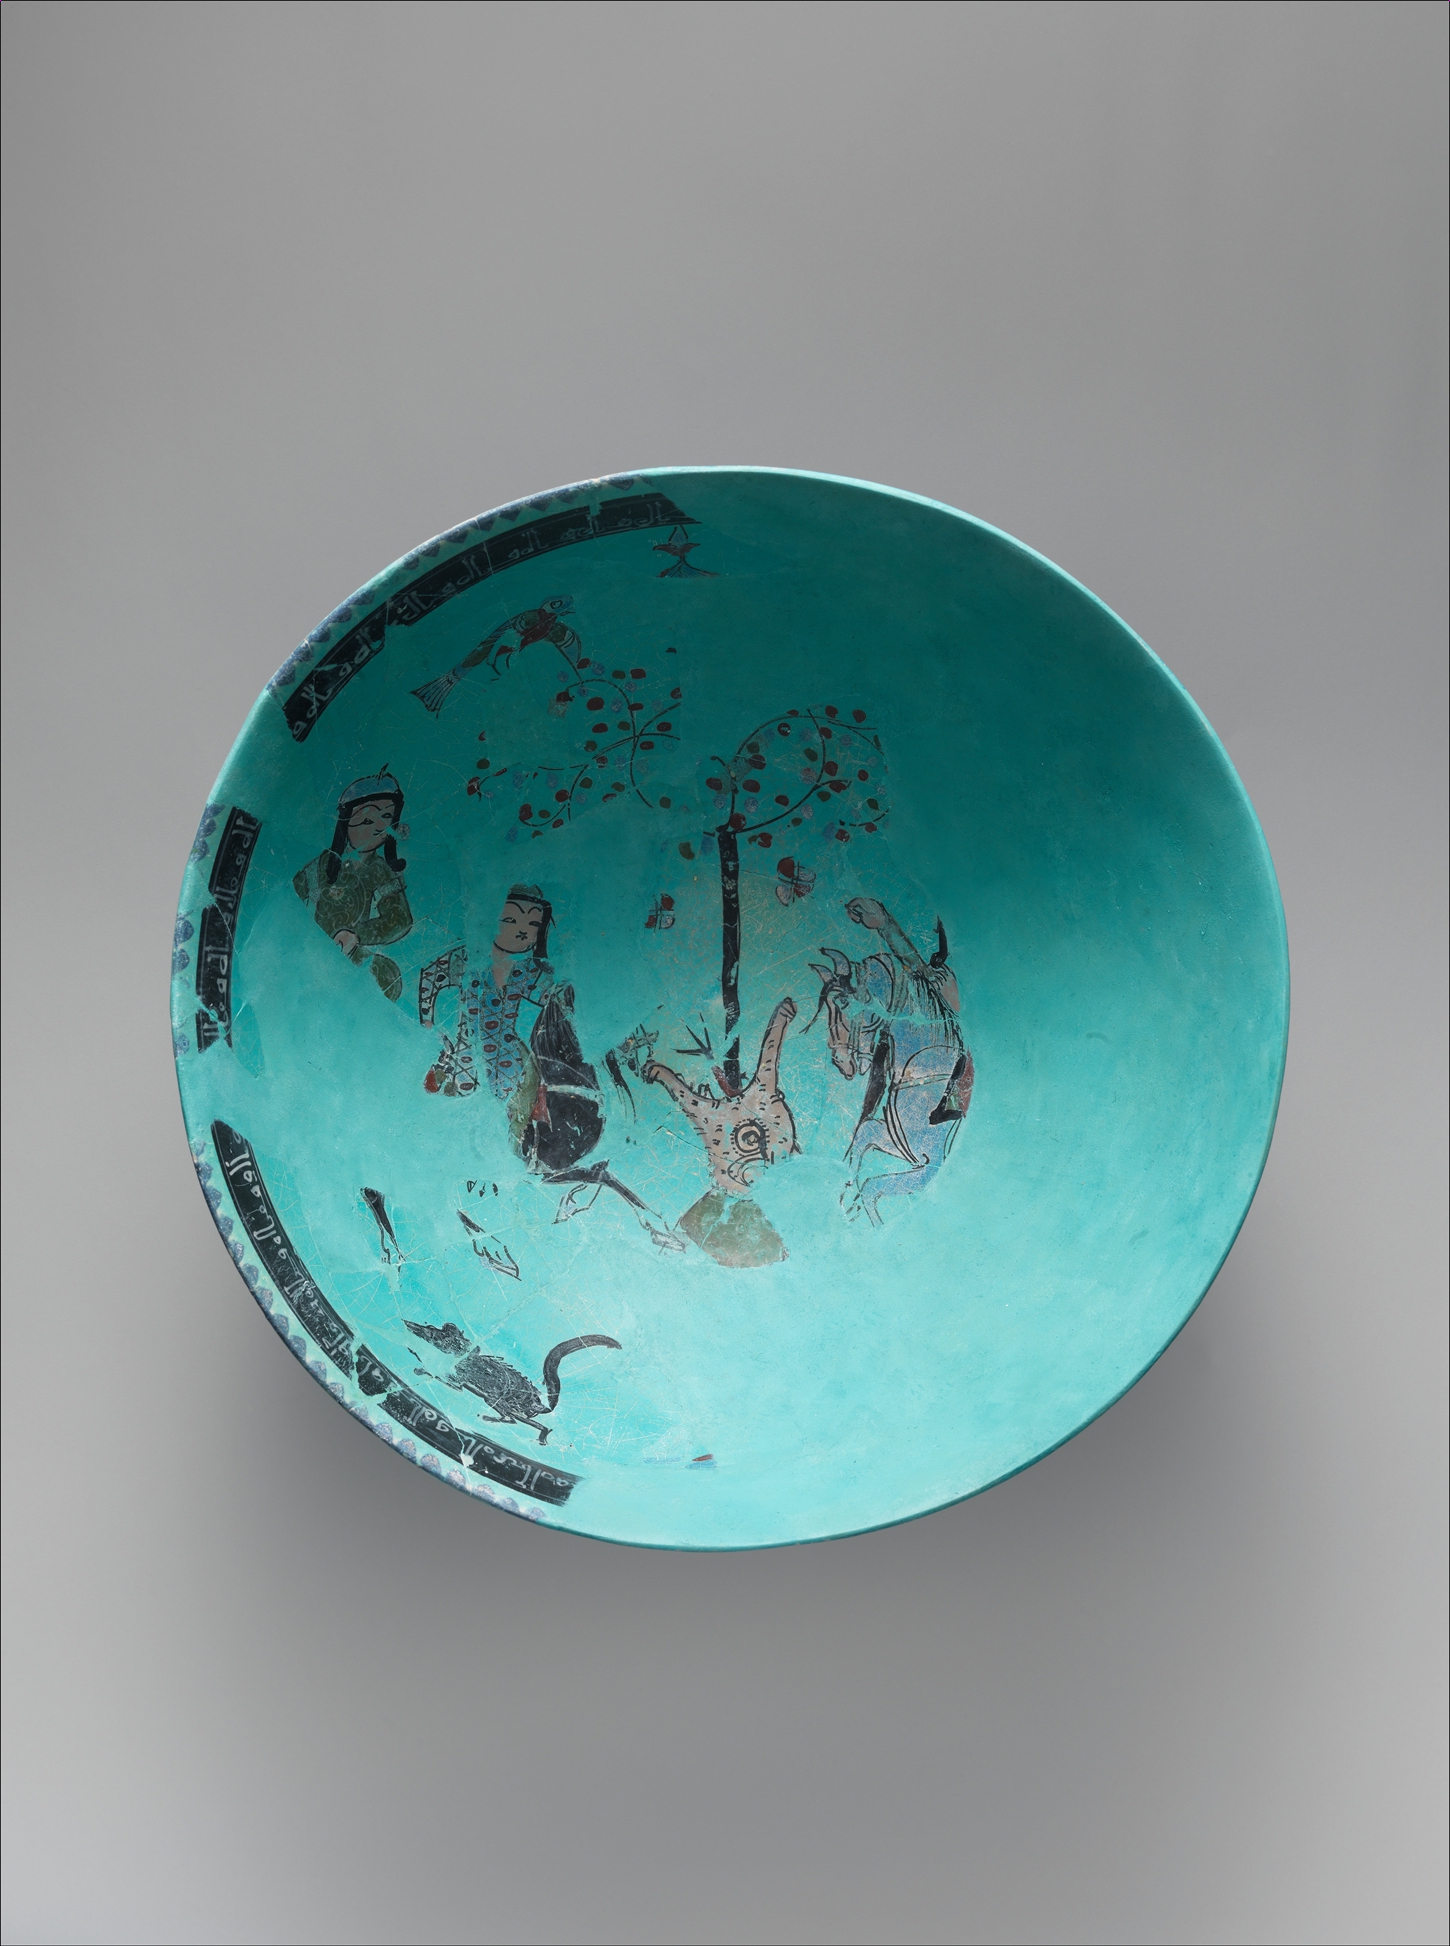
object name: bowl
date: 1101-1300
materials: stonepaste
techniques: overglaze, painting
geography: iran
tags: human figures,birds,horses